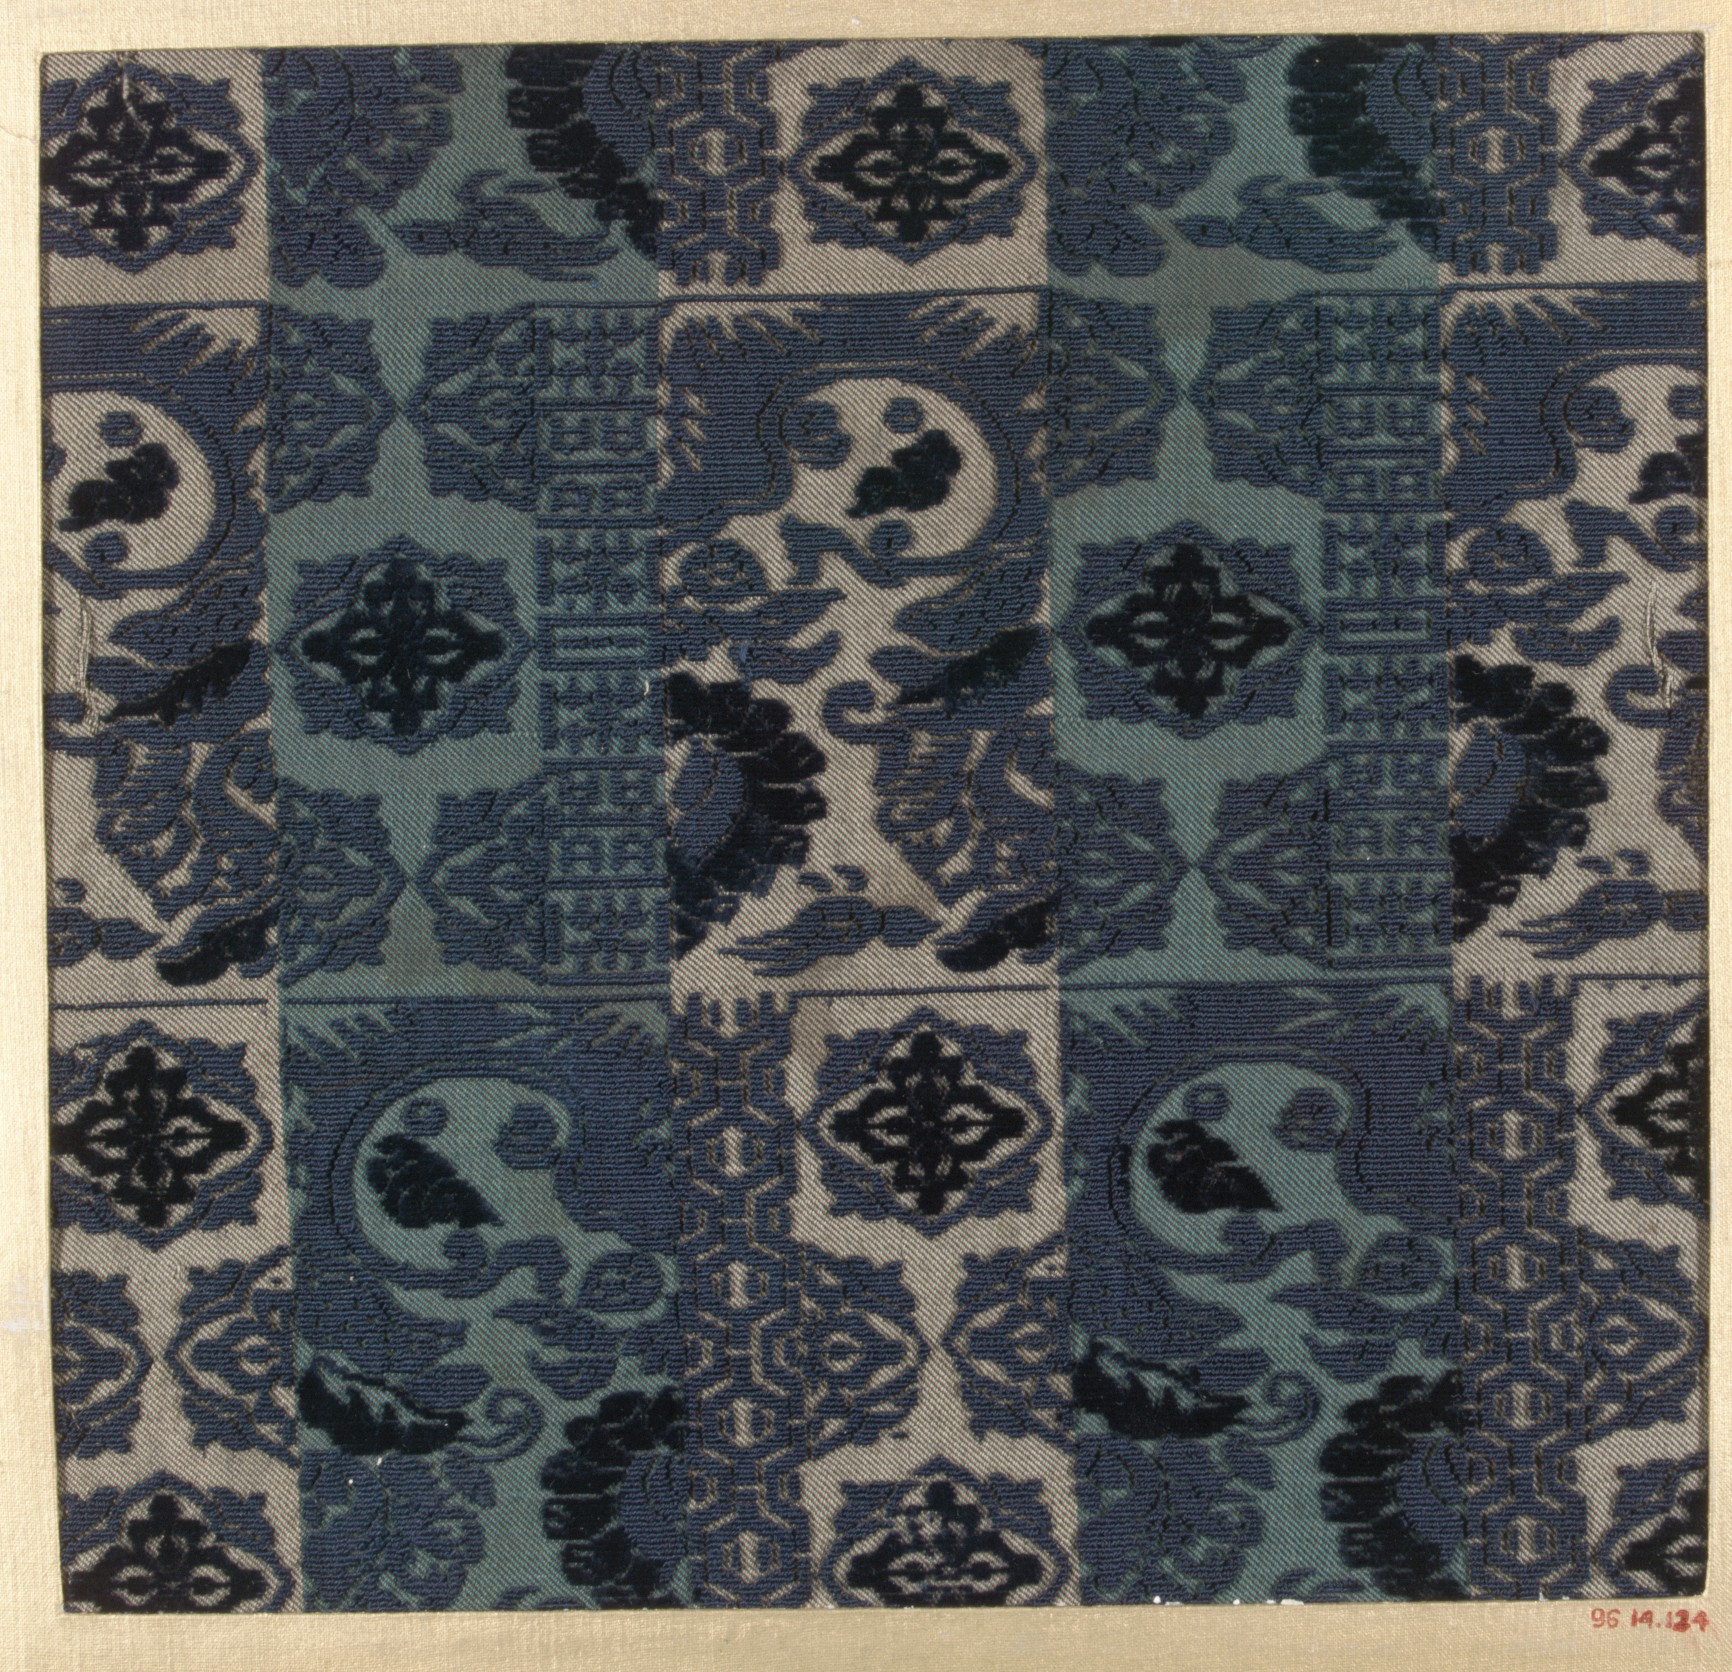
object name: piece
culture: japanese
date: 1701-1900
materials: silk